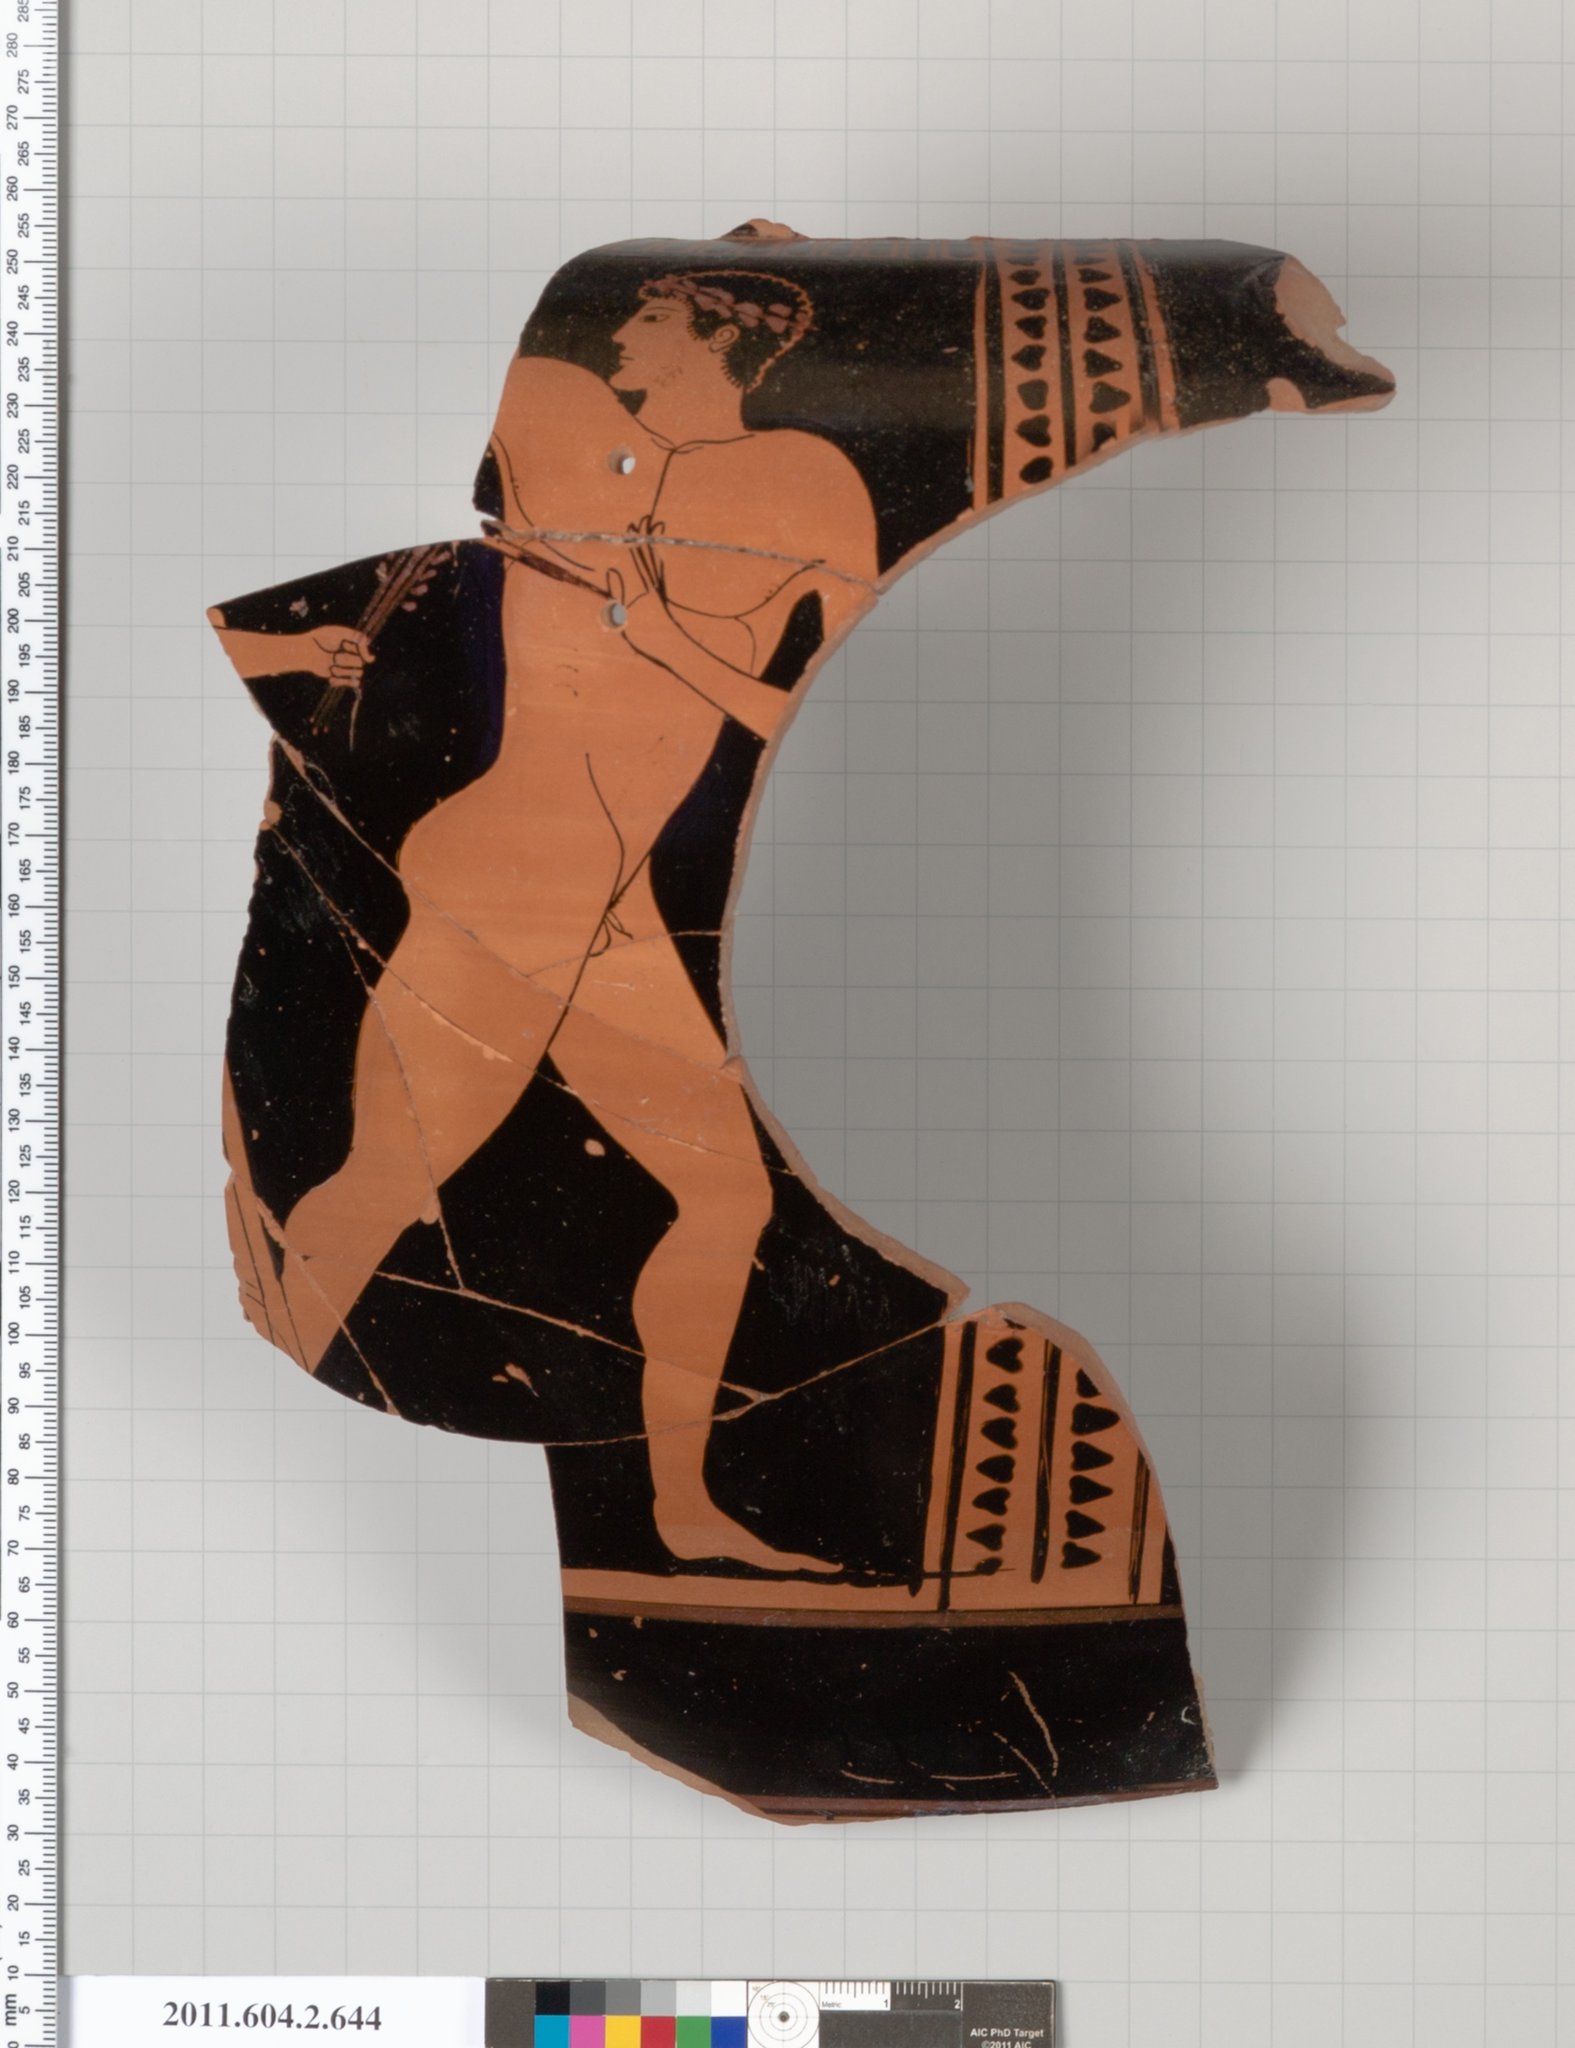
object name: column krater fragment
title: Terracotta fragment of a column-krater (bowl for mixing wine and water)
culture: greek, attic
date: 475-451 BCE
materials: terracotta